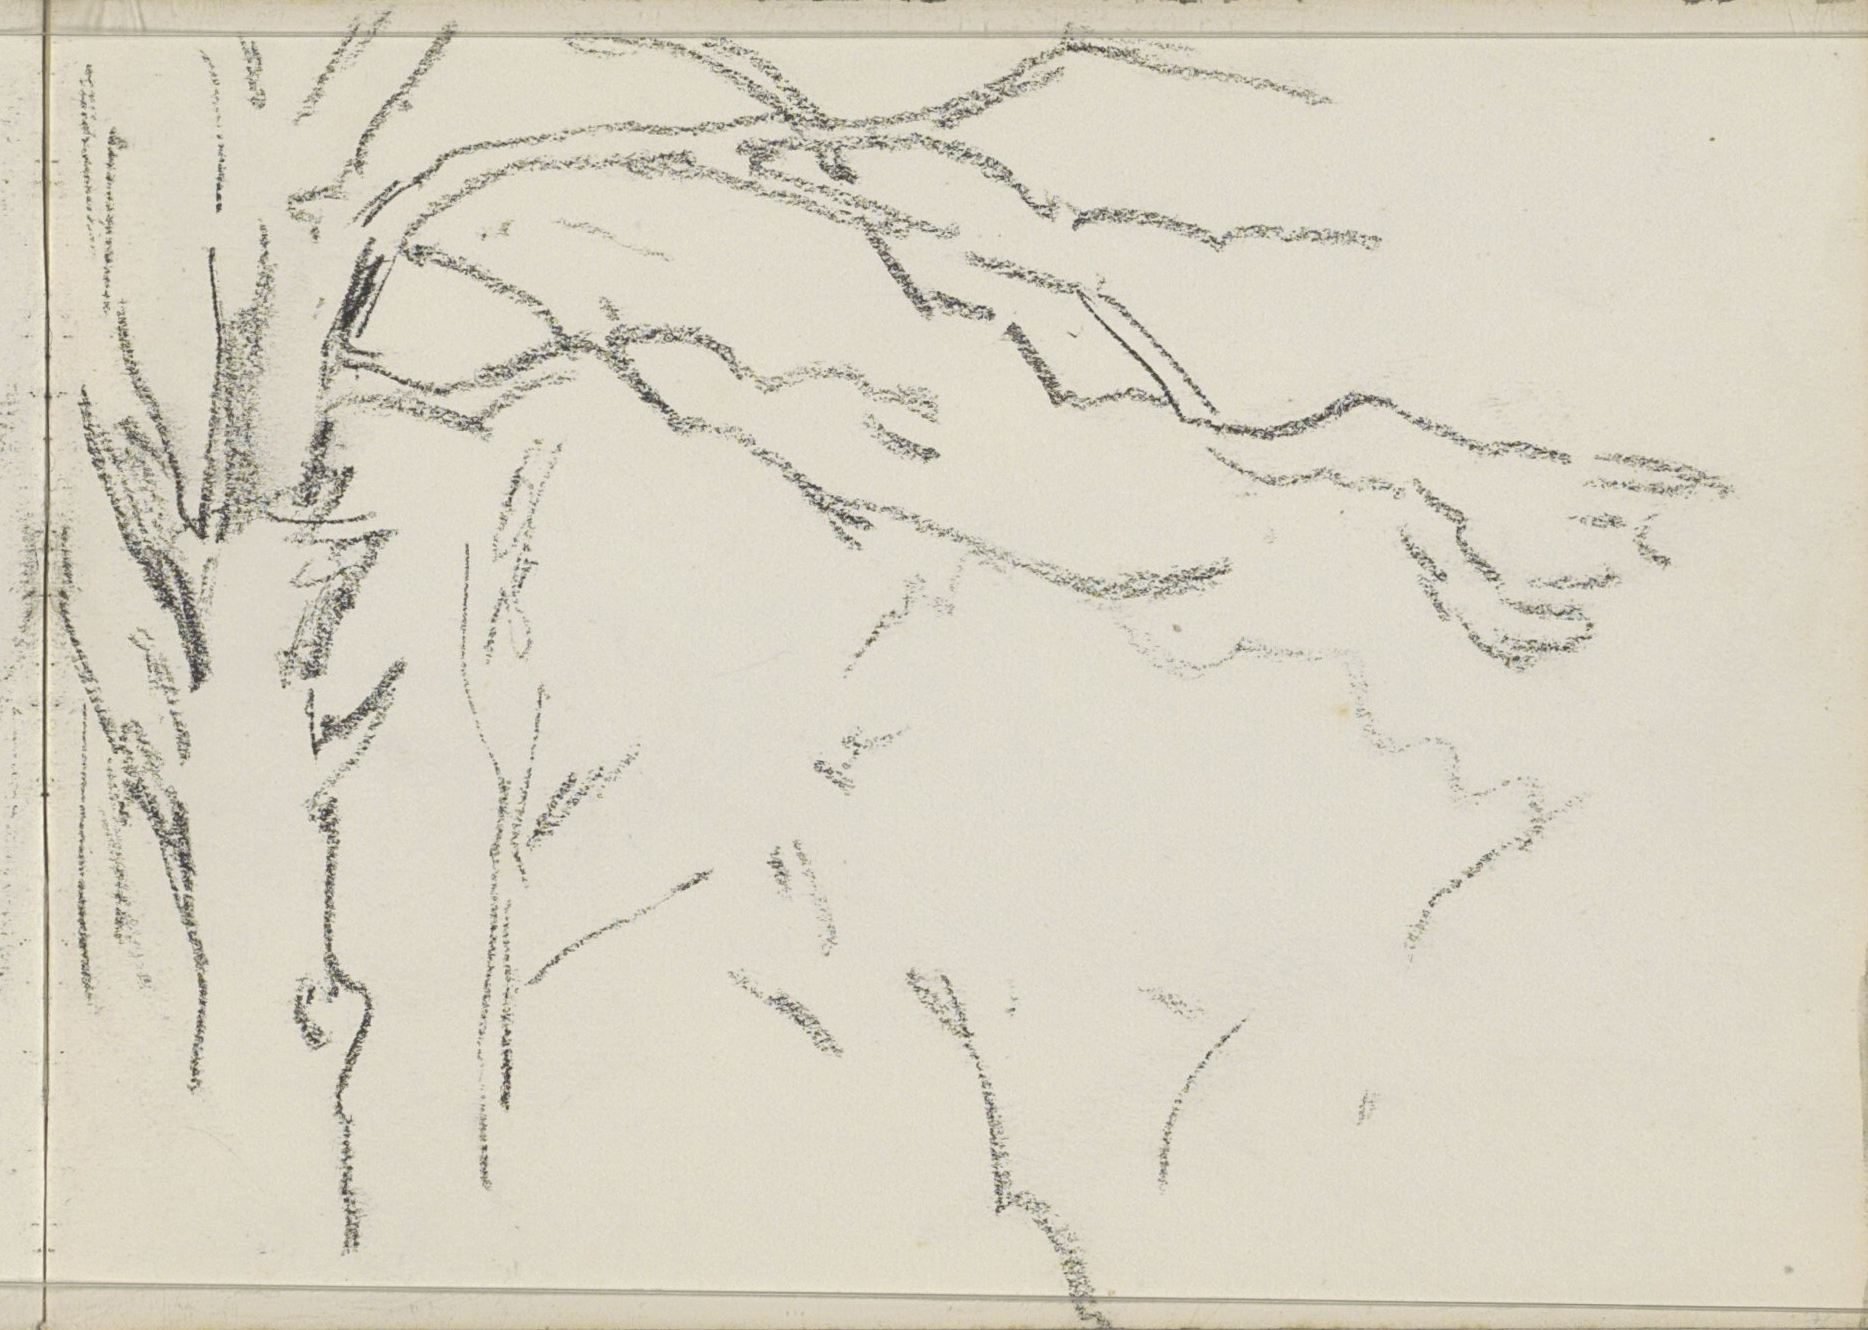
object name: sketchbook leaf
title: Bomen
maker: johan antonie de jonge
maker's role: draughtsman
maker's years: 1864-1927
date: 1920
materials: chalk, paper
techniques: stumping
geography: south holland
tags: trees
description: Bomen. Blad 4 recto uit een schetsboek met 21 bladen.